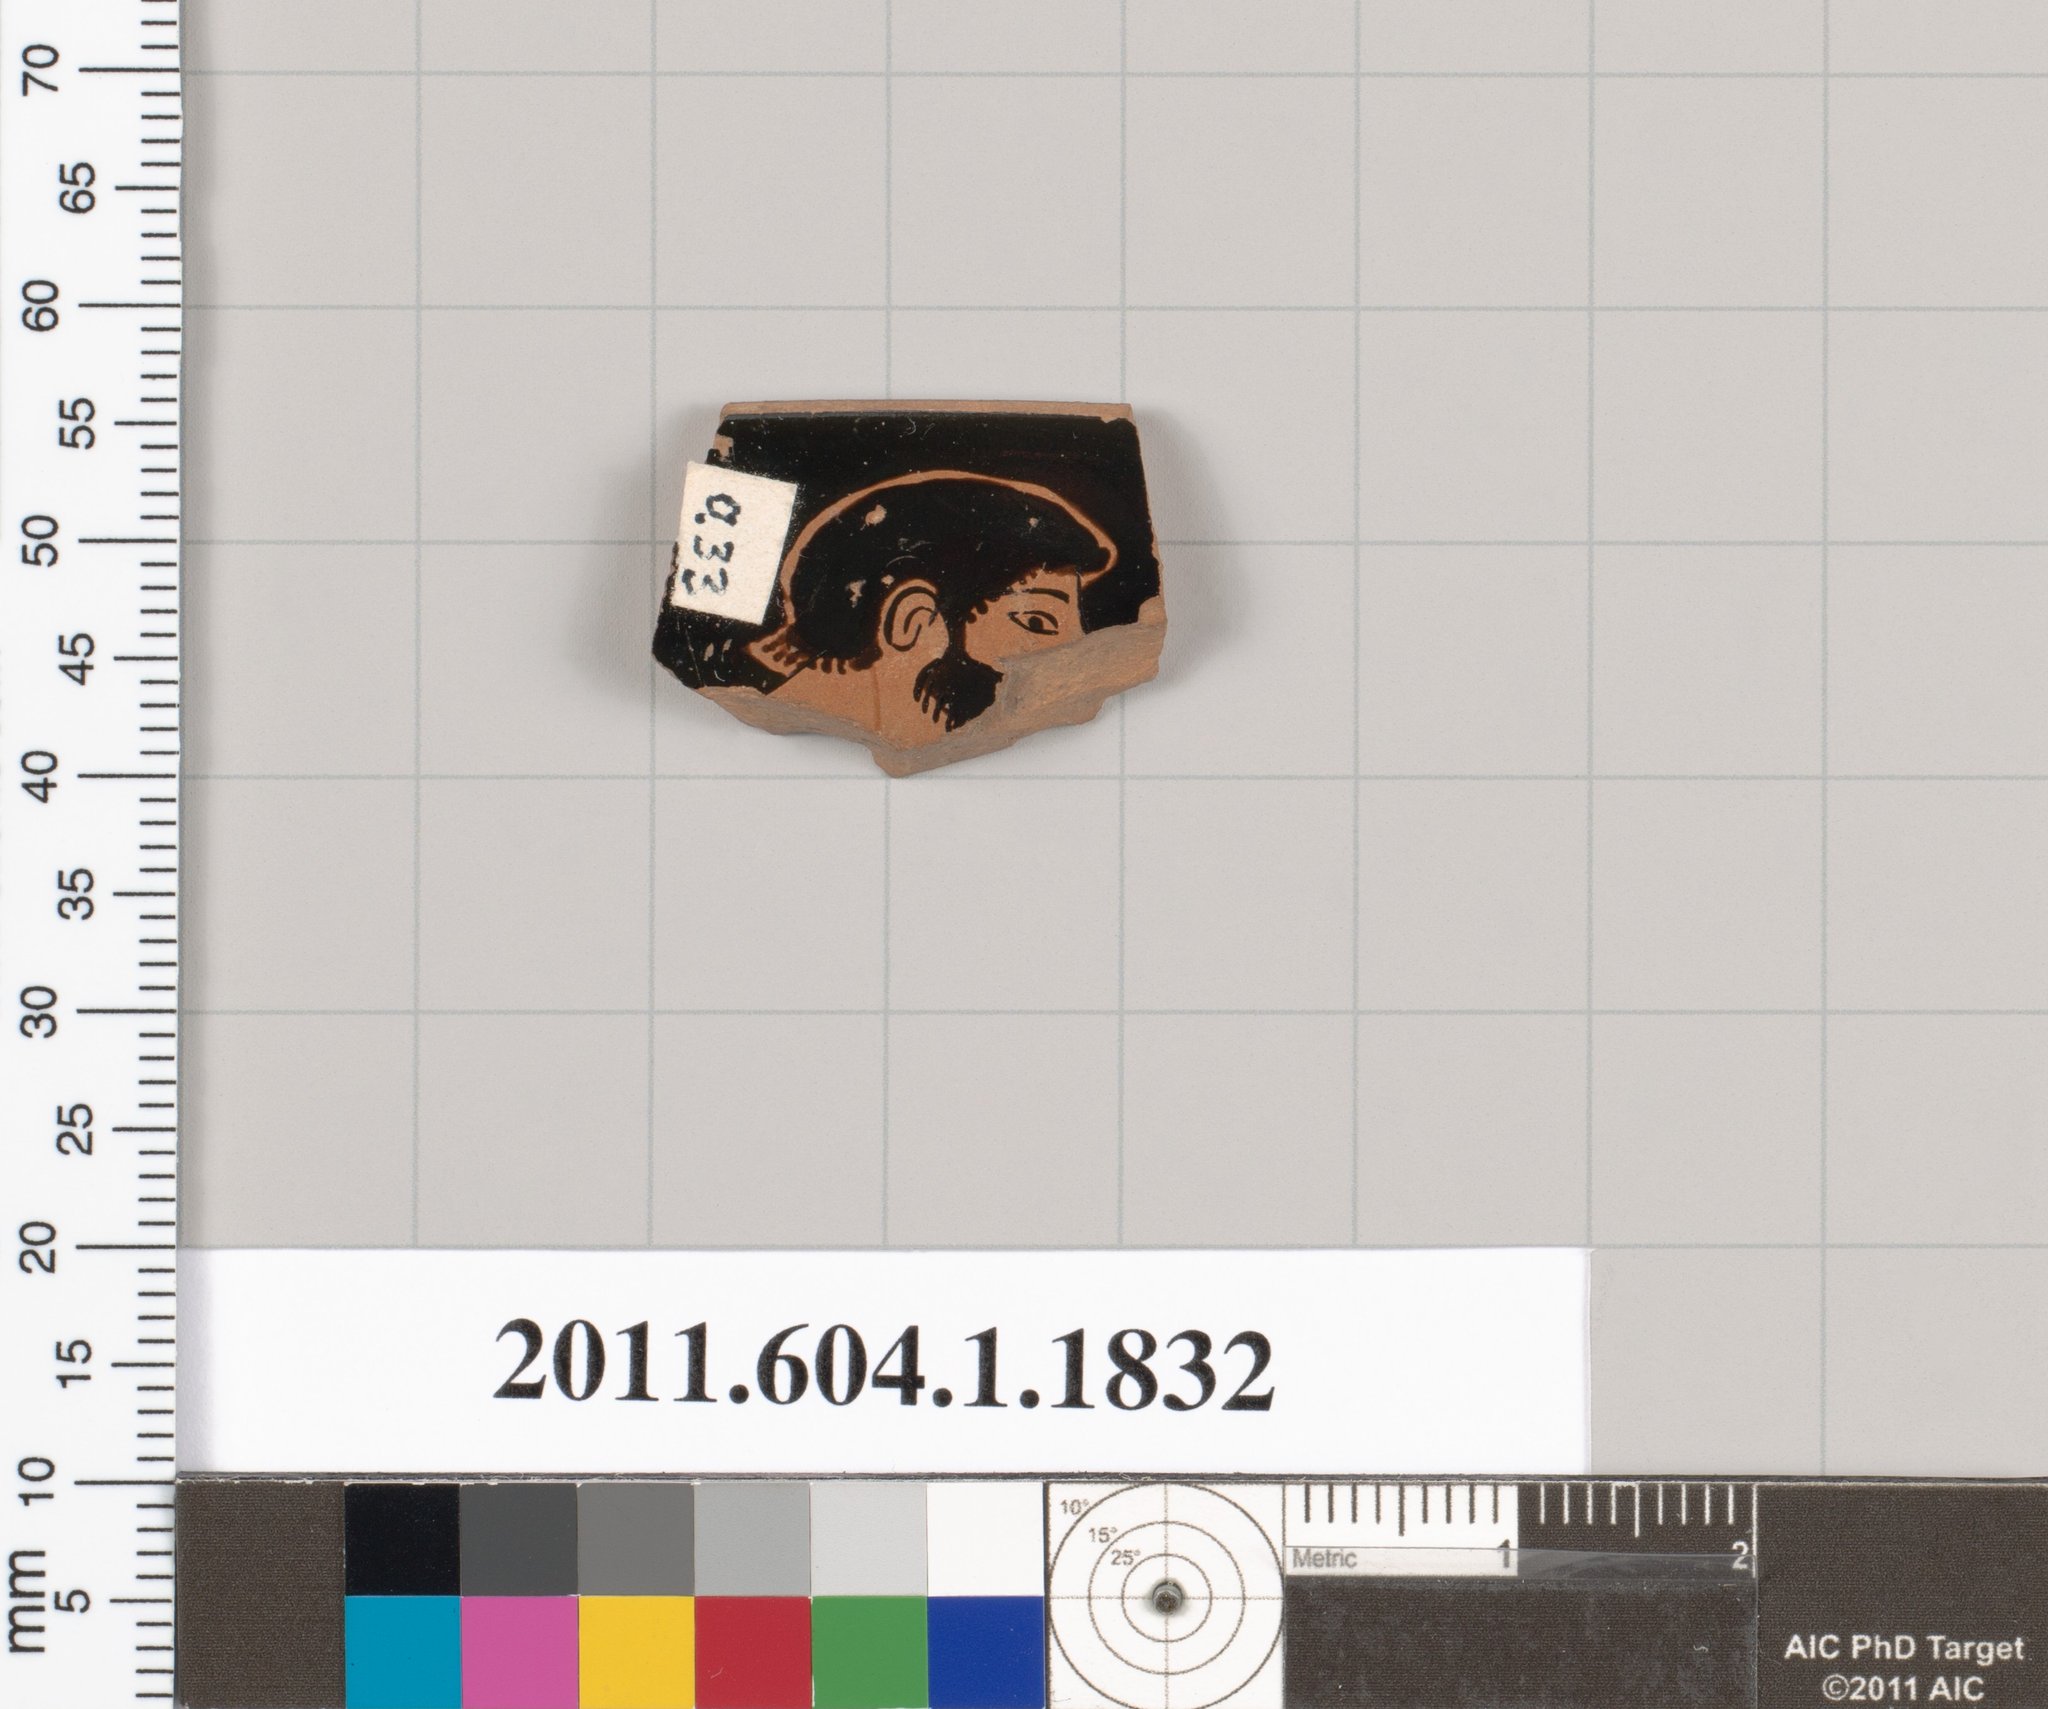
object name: kylix fragment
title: Terracotta rim fragment of a kylix (drinking cup)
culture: greek, attic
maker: clinic painter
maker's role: artist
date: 480-470 BCE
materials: terracotta